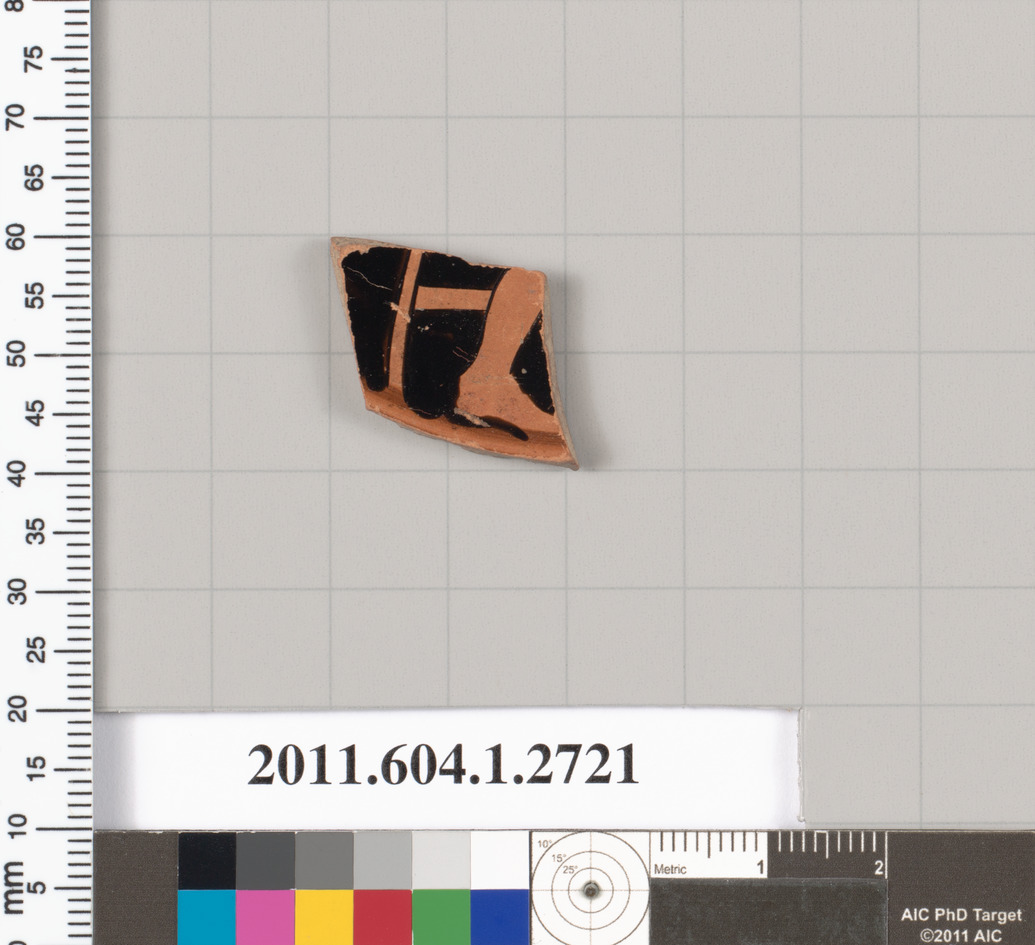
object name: kylix fragment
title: Terracotta fragment of a kylix (drinking cup)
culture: greek, attic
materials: terracotta